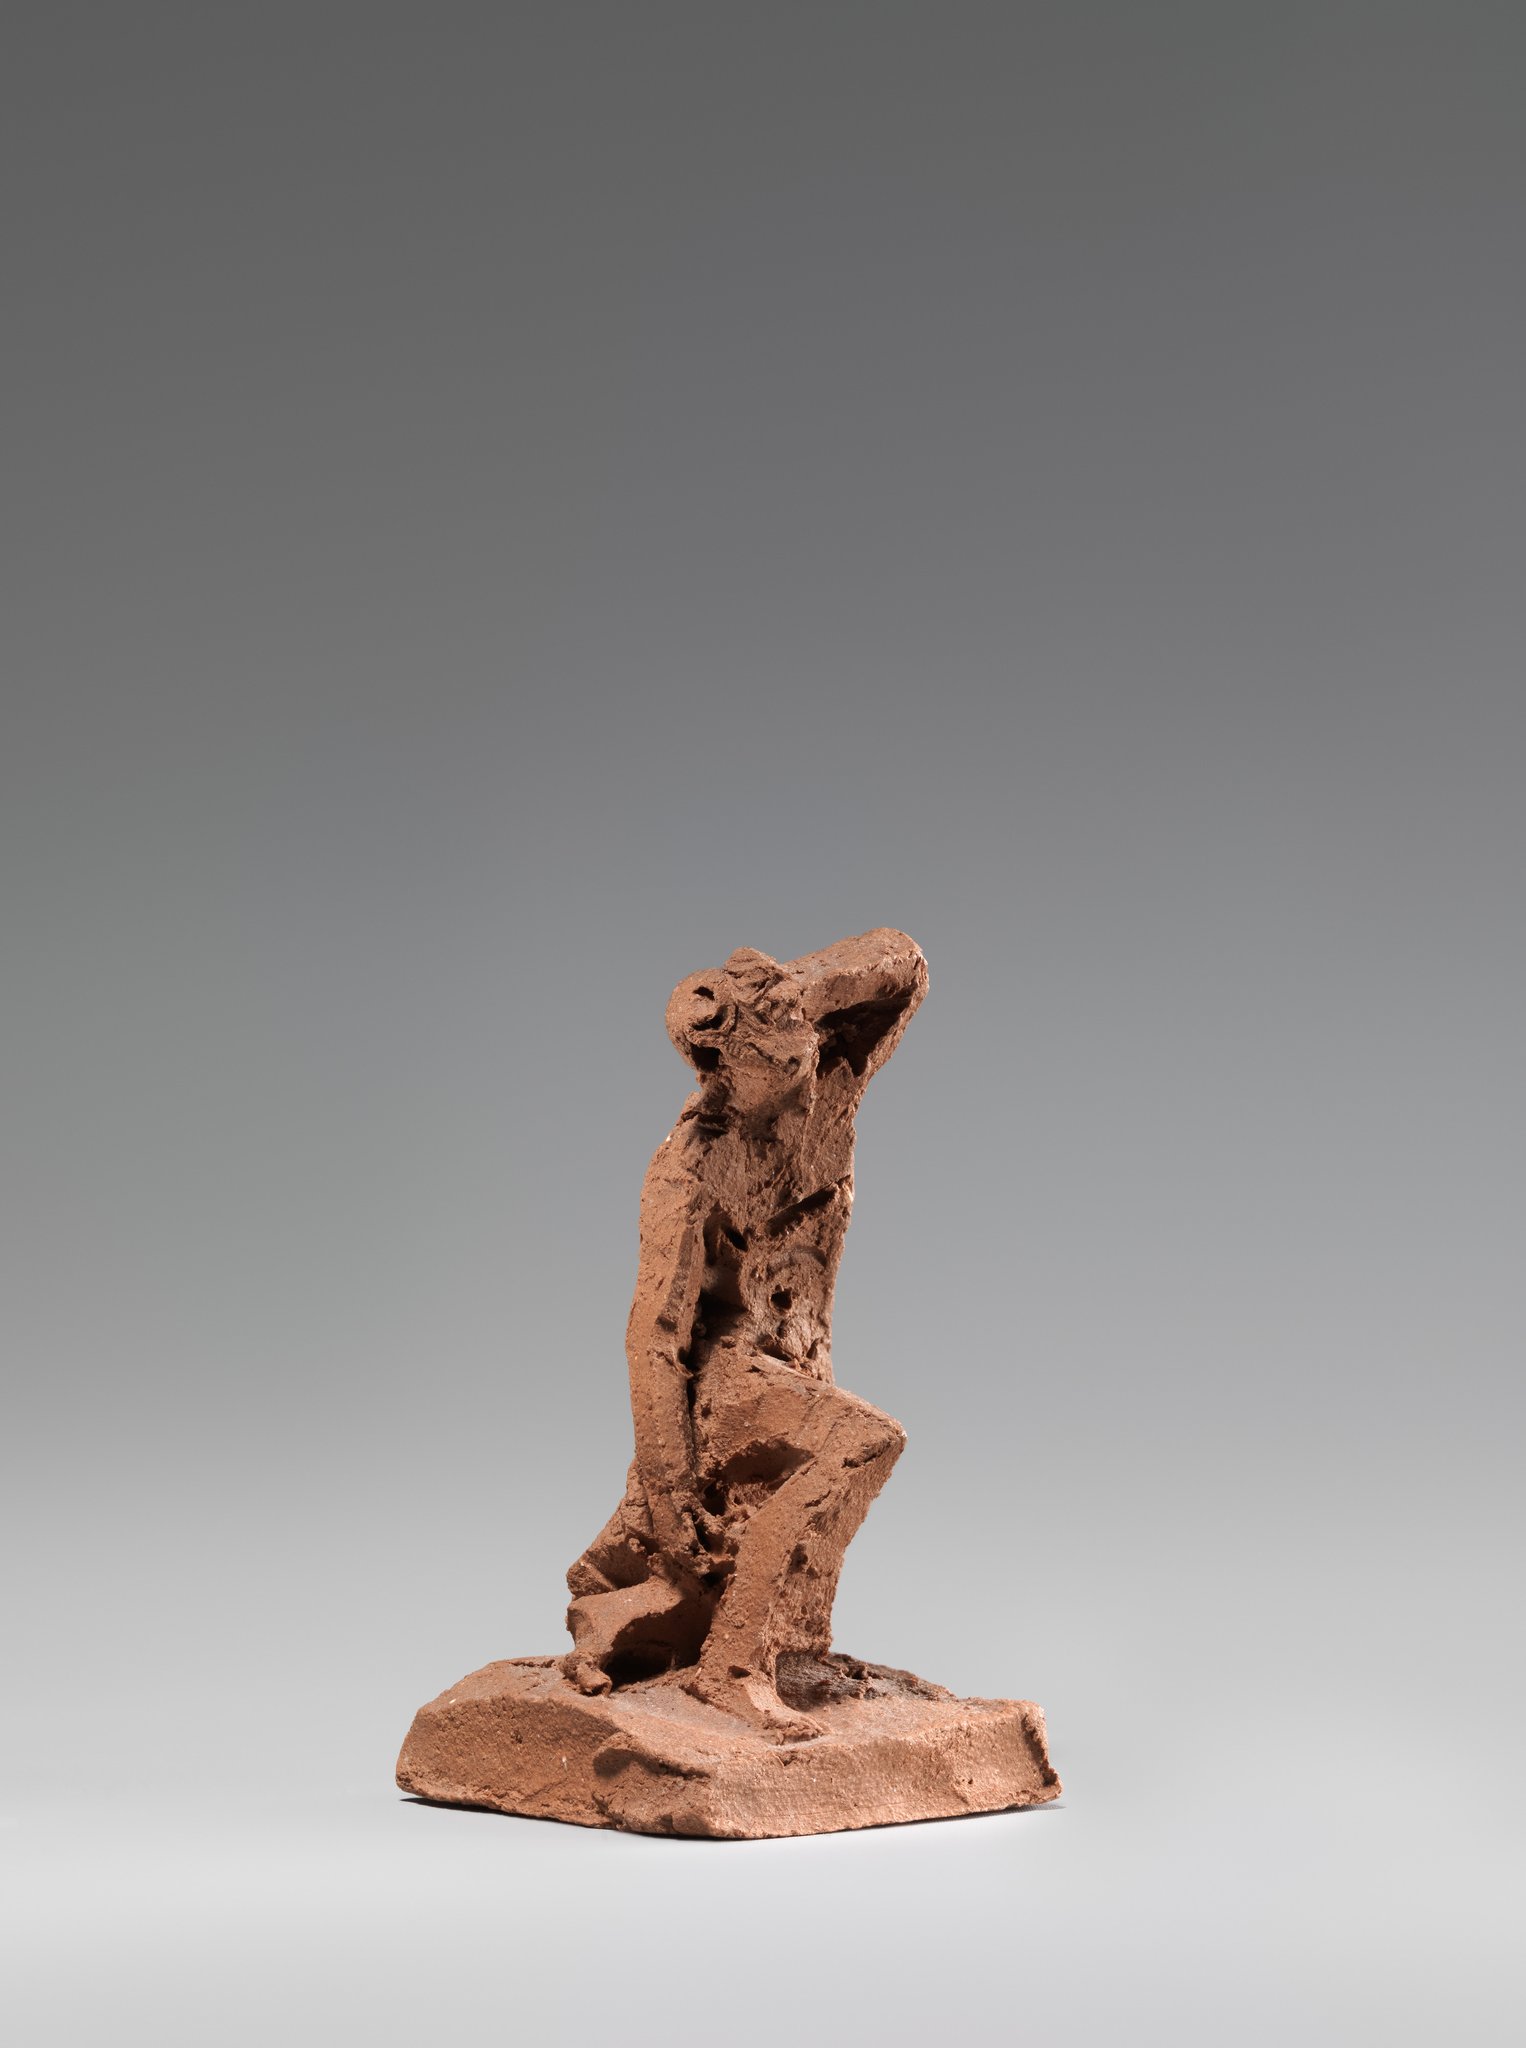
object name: figure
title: Figural study of a man kneeling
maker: jacques-edmé dumont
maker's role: artist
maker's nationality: french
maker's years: 1761-1844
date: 1767-1833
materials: terracotta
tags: men